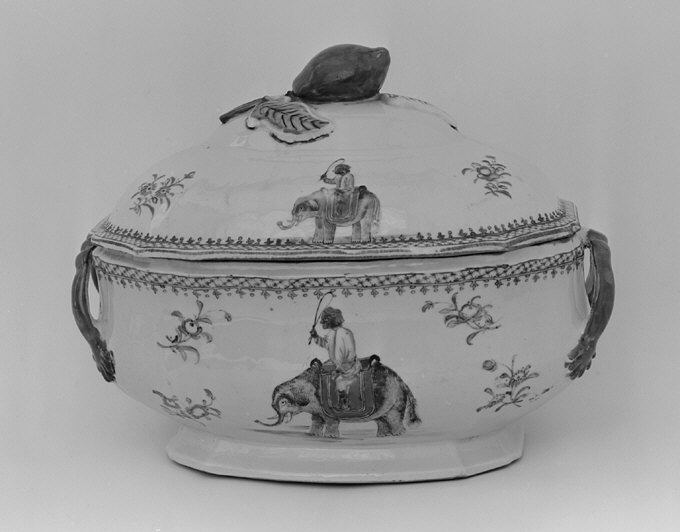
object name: tureen with cover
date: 1785-1800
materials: hard paste porcelain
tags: men,elephants